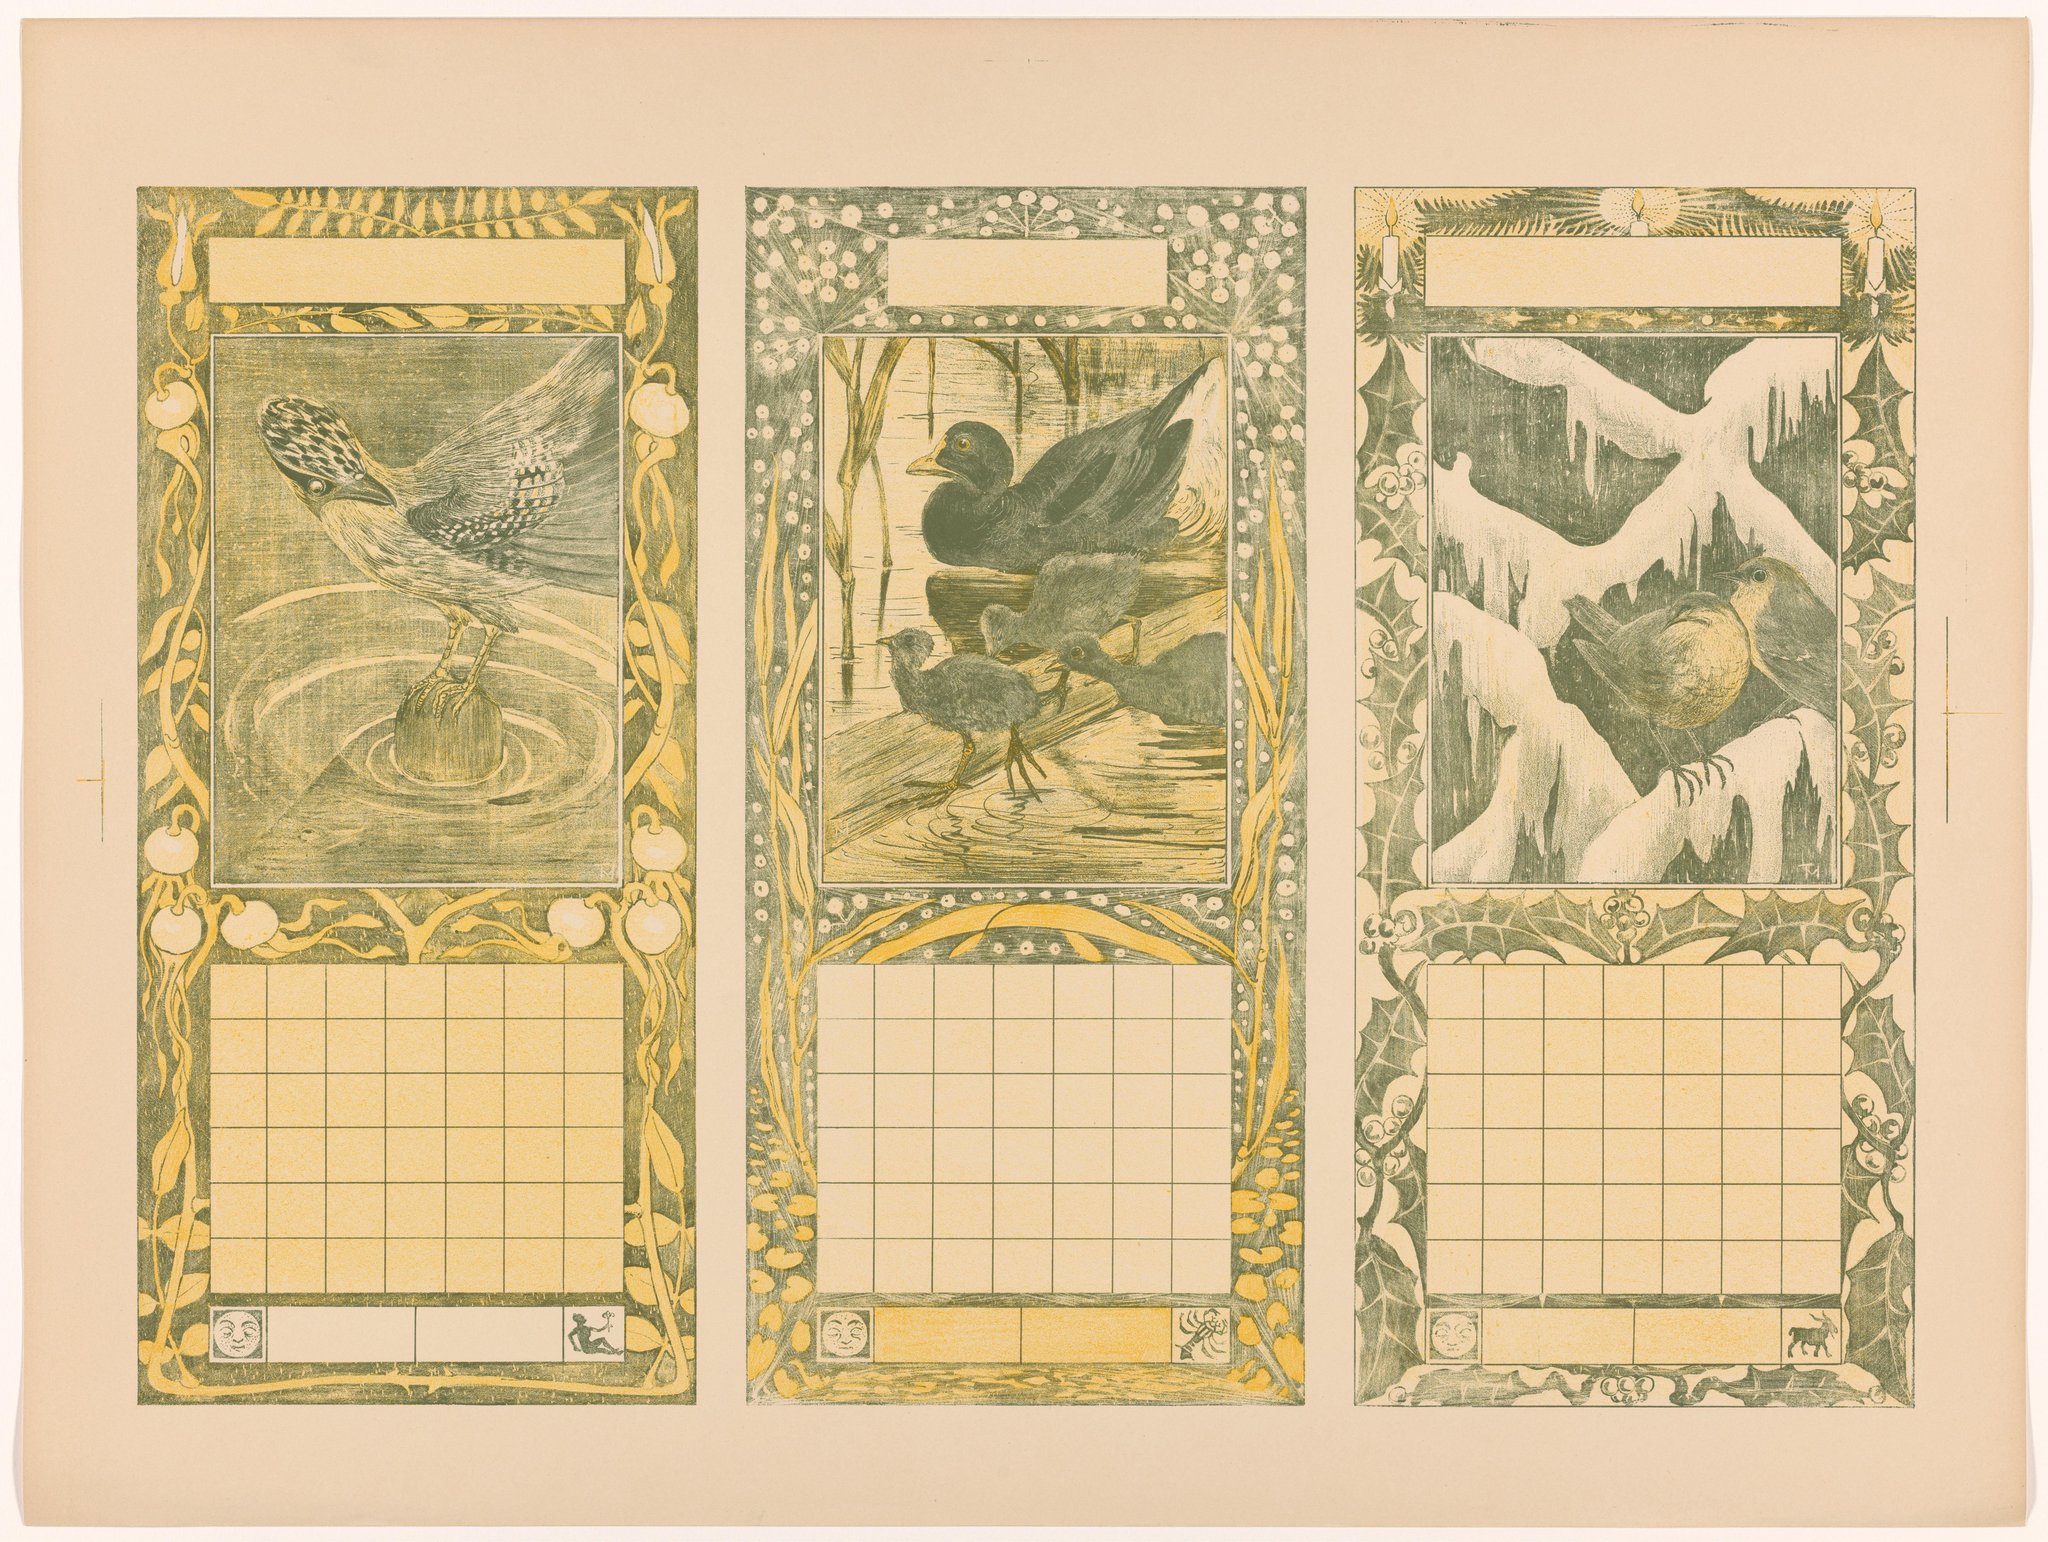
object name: print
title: Kalenders voor augustus, juni en december 1904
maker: theo van hoytema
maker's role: draughtsman, painter, print maker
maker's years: 1863-1917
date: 1904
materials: paper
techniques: lithograph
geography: amsterdam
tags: calendar, almanac, water-birds: swamp-hen, song-birds: robin, song-birds: jay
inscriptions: collector's mark: Lugt 2233